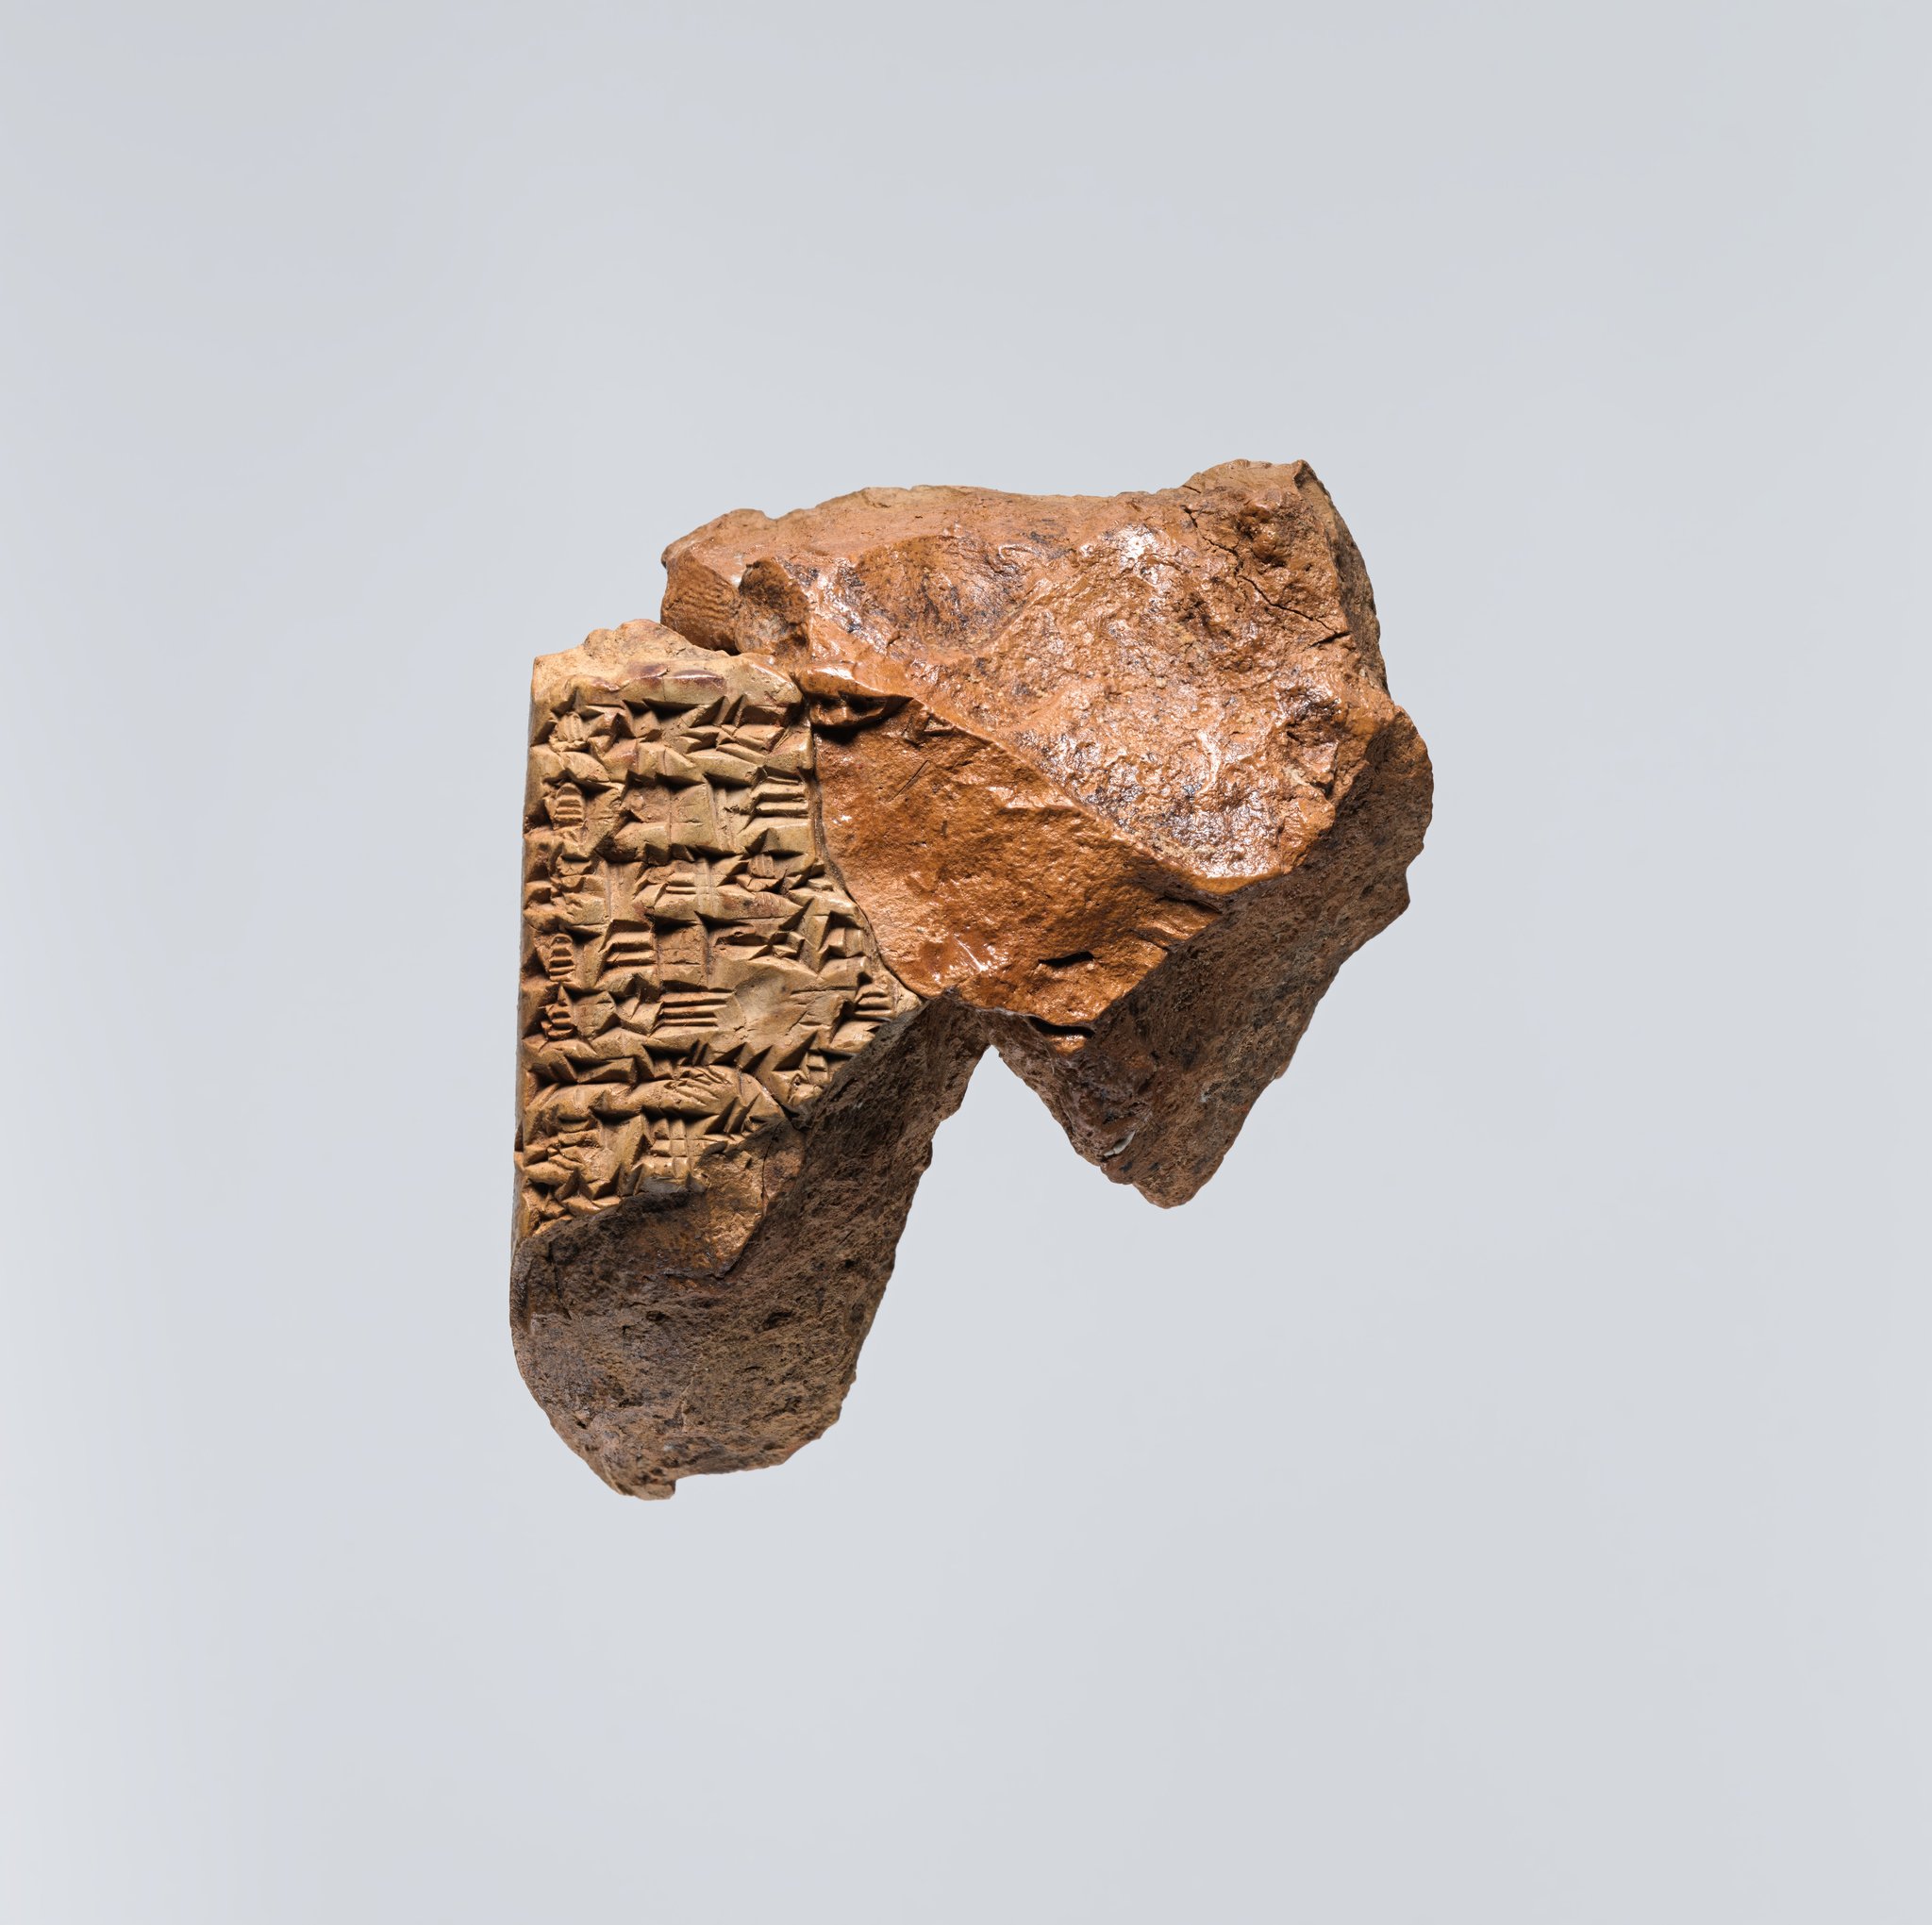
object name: cuneiform tablet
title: Cuneiform tablet: Atra-hasis, Babylonian flood myth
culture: achaemenid or babylonian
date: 700-501 BCE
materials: clay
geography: mesopotamia